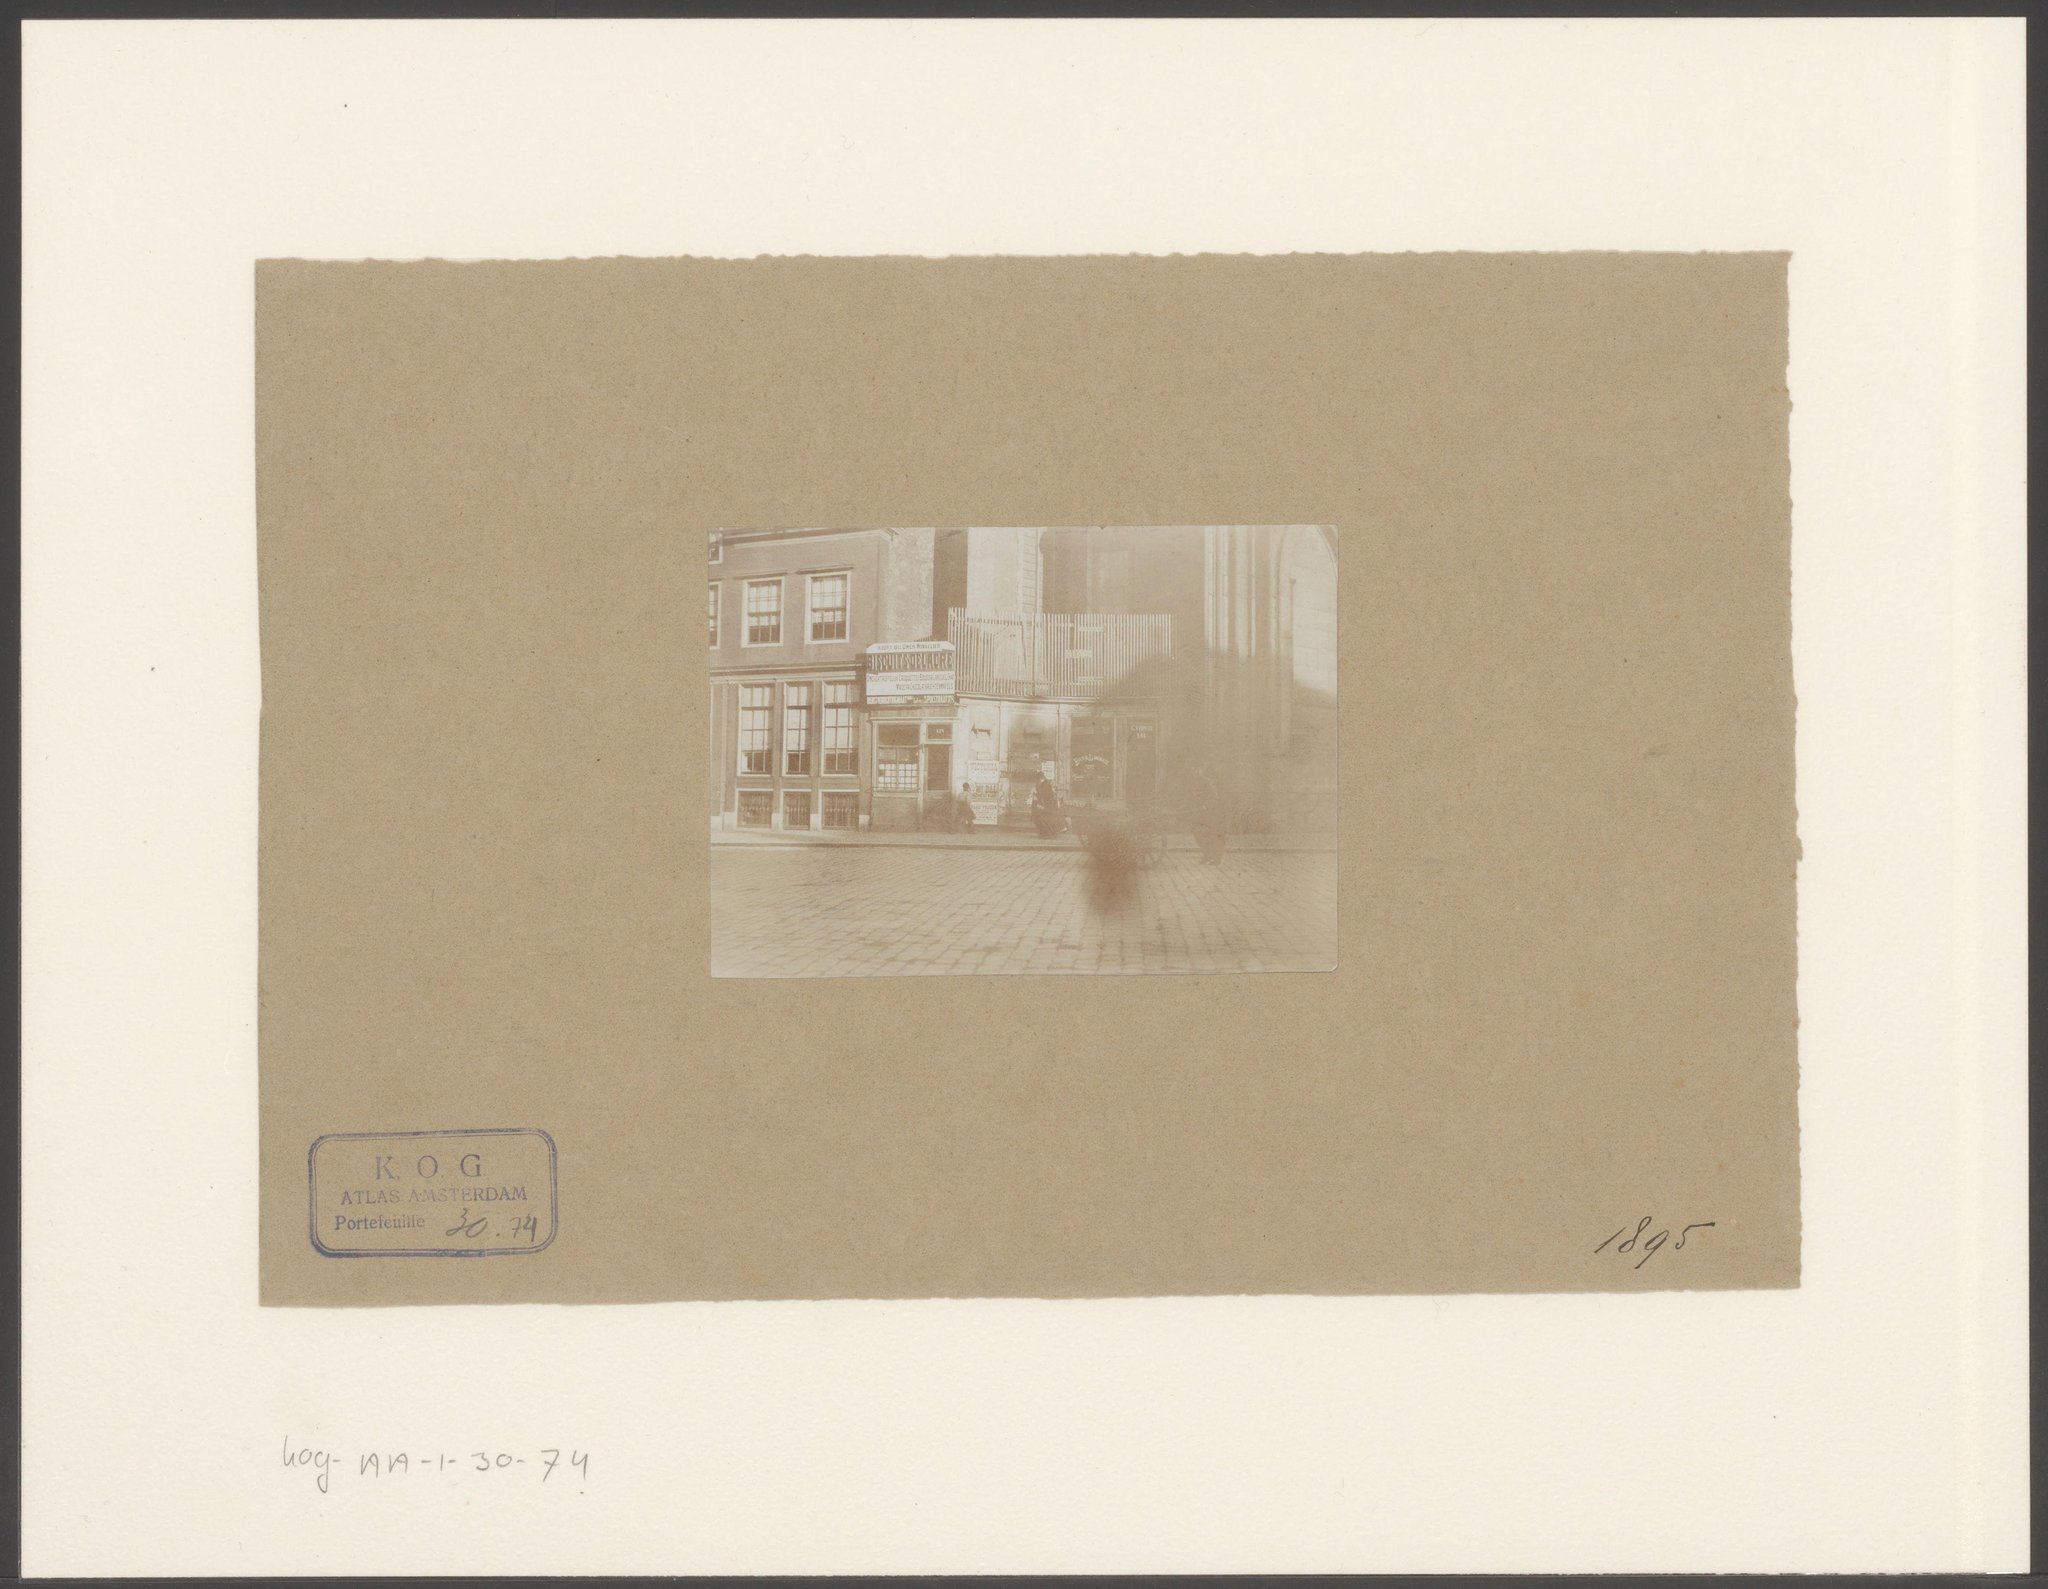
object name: photograph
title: Winkels aan de Nieuwe Kerk te Amsterdam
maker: Anonymous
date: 1880-1895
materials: paper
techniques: collodion silver print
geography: amsterdam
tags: shop, store, church (exterior), street (+ city(-scape) with figures, staffage)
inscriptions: inscription: ‘photogr: van C.W. Crone’, collector's mark: Lugt 1641b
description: Onderwerpsrubriek binnen de Atlas Amsterdam: Kerkwezen: Hervormde Gemeente: Nieuwe Kerk van buiten.